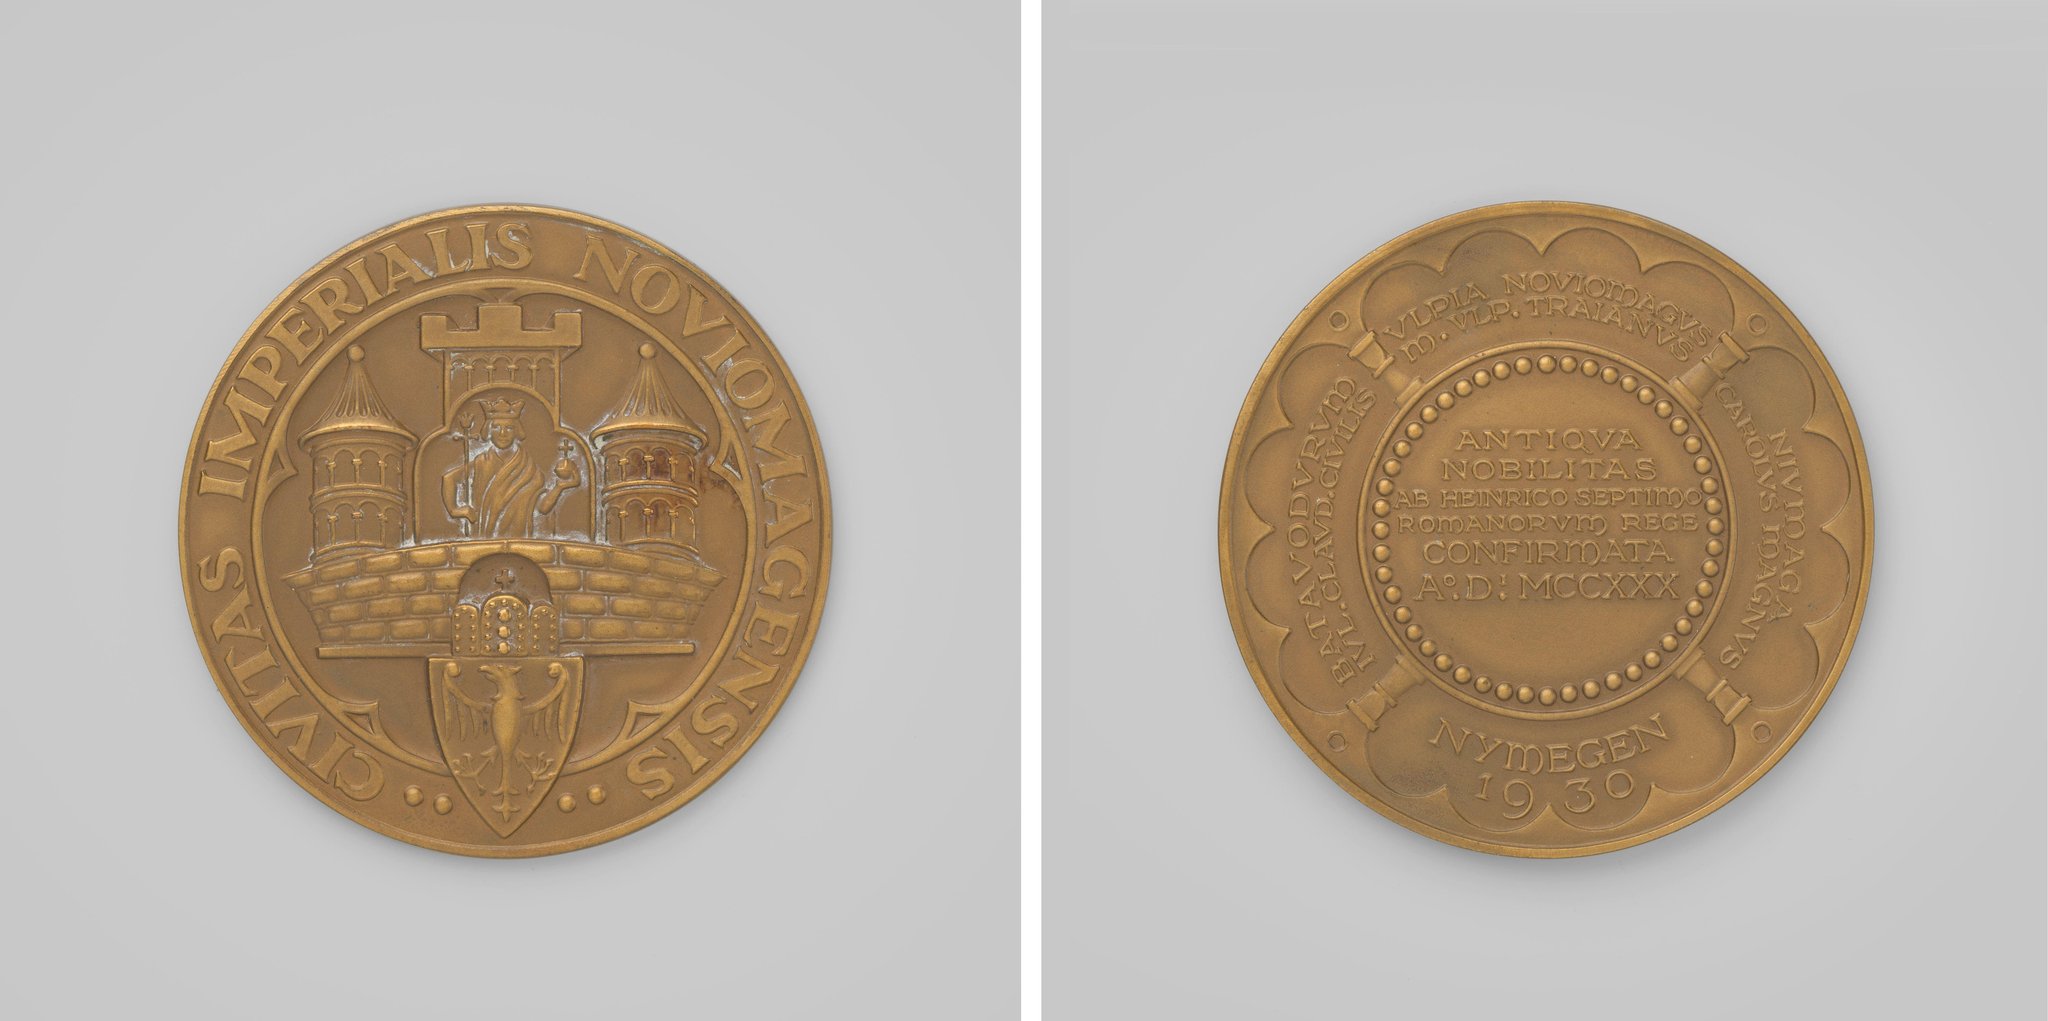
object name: history medal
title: Nijmegen 700 jaar keizerlijke stad 1930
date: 1930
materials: bronze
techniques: striking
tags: nijmegen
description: Bronzen penning Nijmegen 700 jaar keizerlijke stad: voorzijde: man (keizer Hendrik VII) op kasteelmuur, waaronder stadswapen (Nijmegen) met keizerskroon, binnen omschrift 'CIVITAS IMPERIALIS NOVIOMAGENSIS', keerzijde opschrift binnen parelrand ('ANTIQUA / NOBILITAS / AB HENRICO SEPTIMO / ROMANORUM REGE / CONFIRMATA / AO. DI. MDCXXX'), waaromheen vier op pilaren rustende gewelven waarin opschriften over Claudius Civilis, Trajanus en Karel de Grote, en onder opschrift 'NIJMEGEN 1930'.